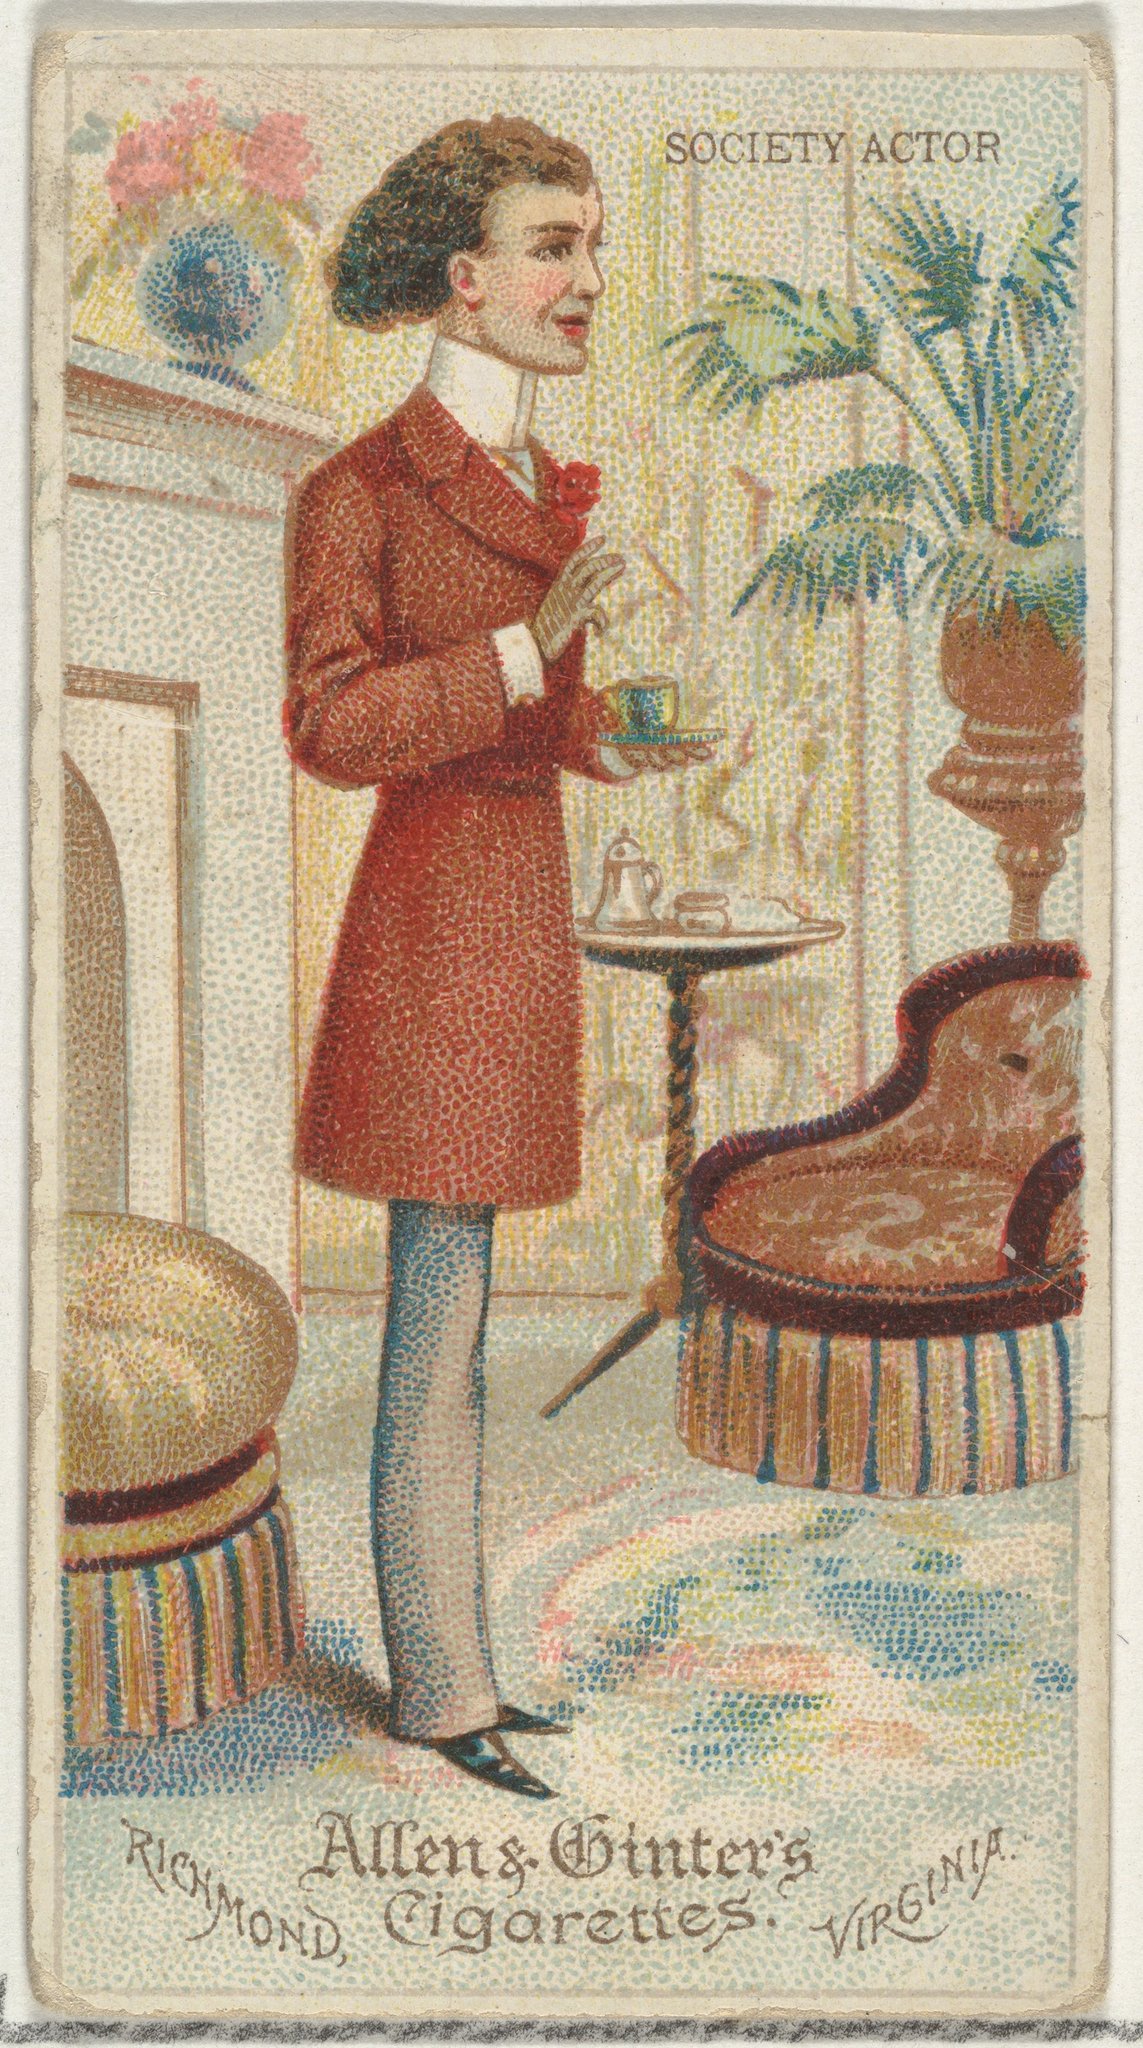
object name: print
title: Society Actor, from World's Dudes series (N31) for Allen & Ginter Cigarettes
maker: allen & ginter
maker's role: publisher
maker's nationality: american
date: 1888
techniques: color lithograph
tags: men,actors